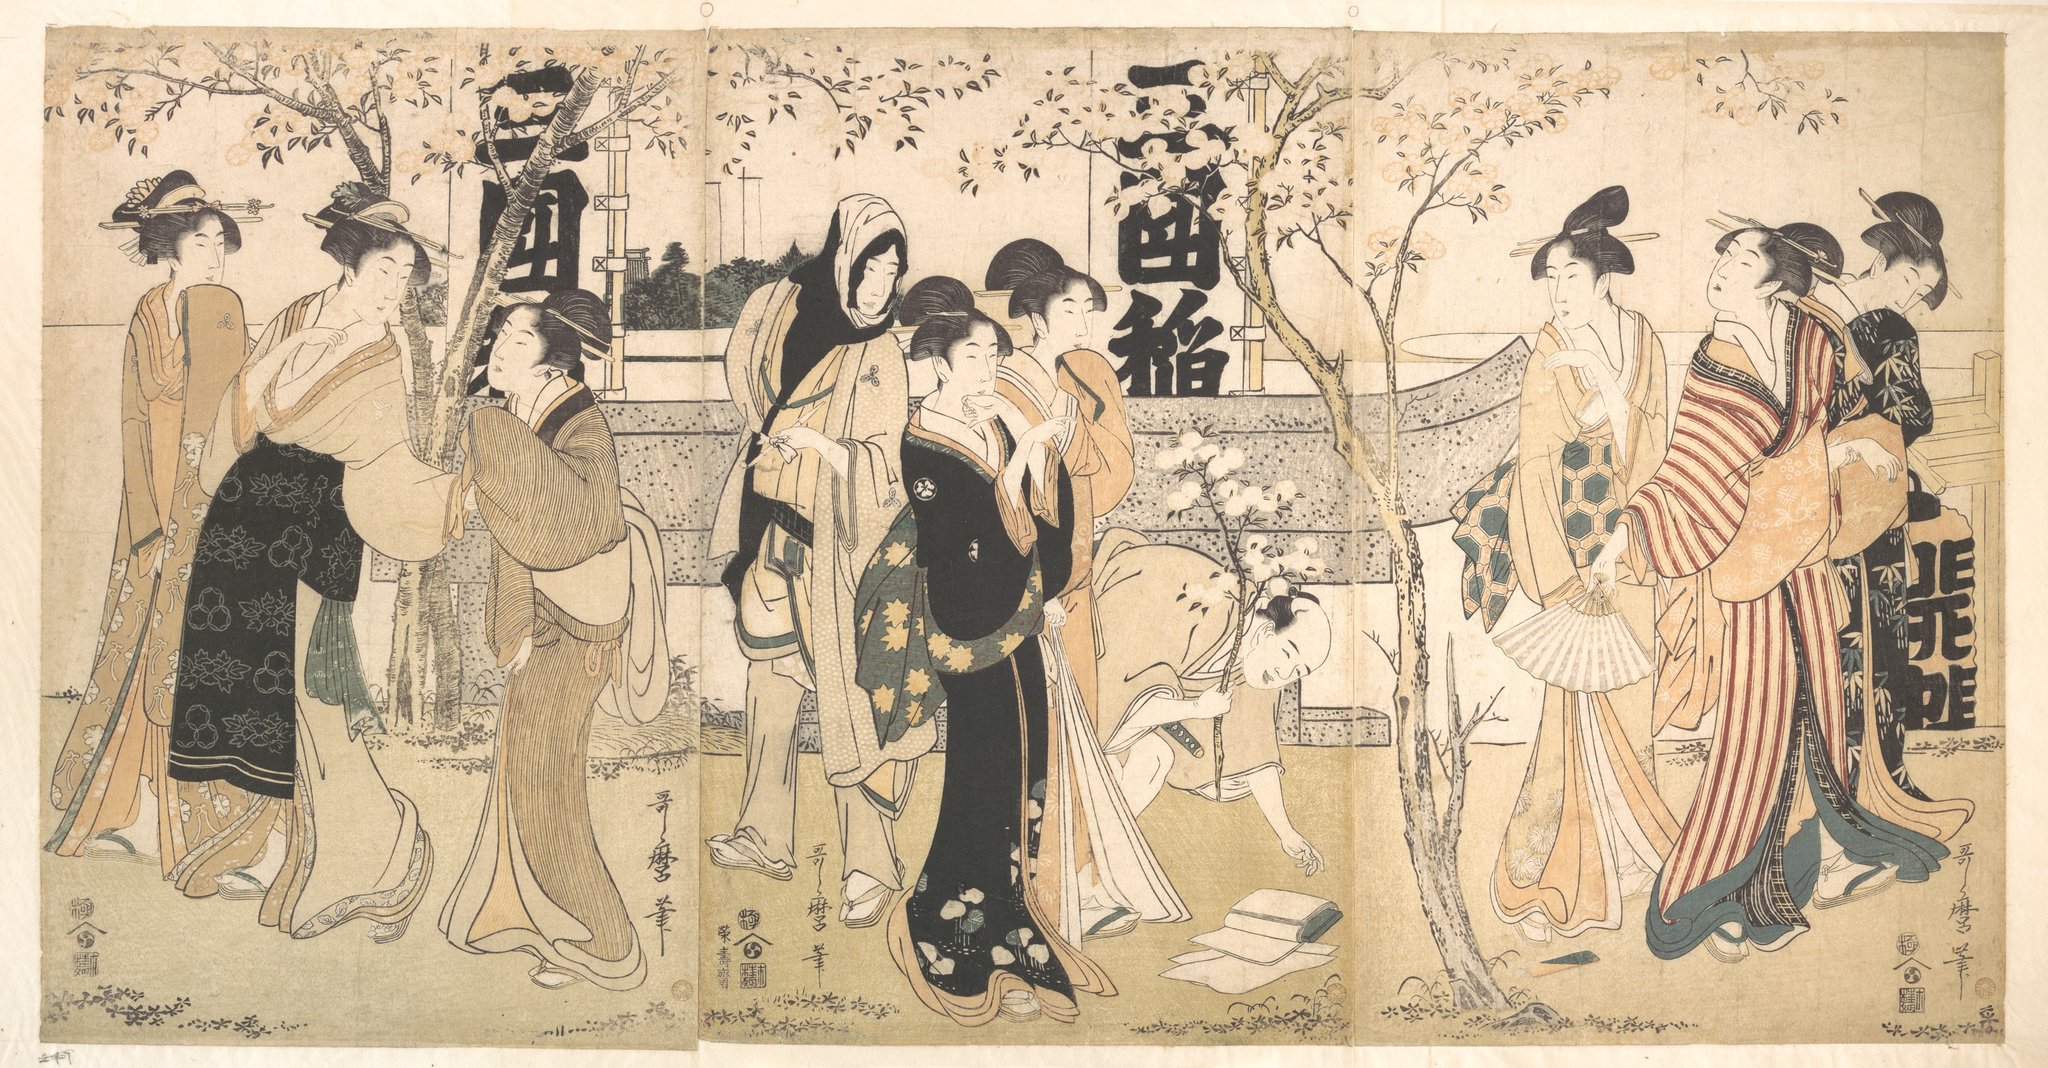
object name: print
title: Display of Treasures at Mimeguri Shrine (Mimeguri jinja no onkaichō)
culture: japanese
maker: kitagawa utamaro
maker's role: artist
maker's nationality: japanese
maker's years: 1754-1806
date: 1799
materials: ink, paper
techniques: woodblock print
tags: women,trees